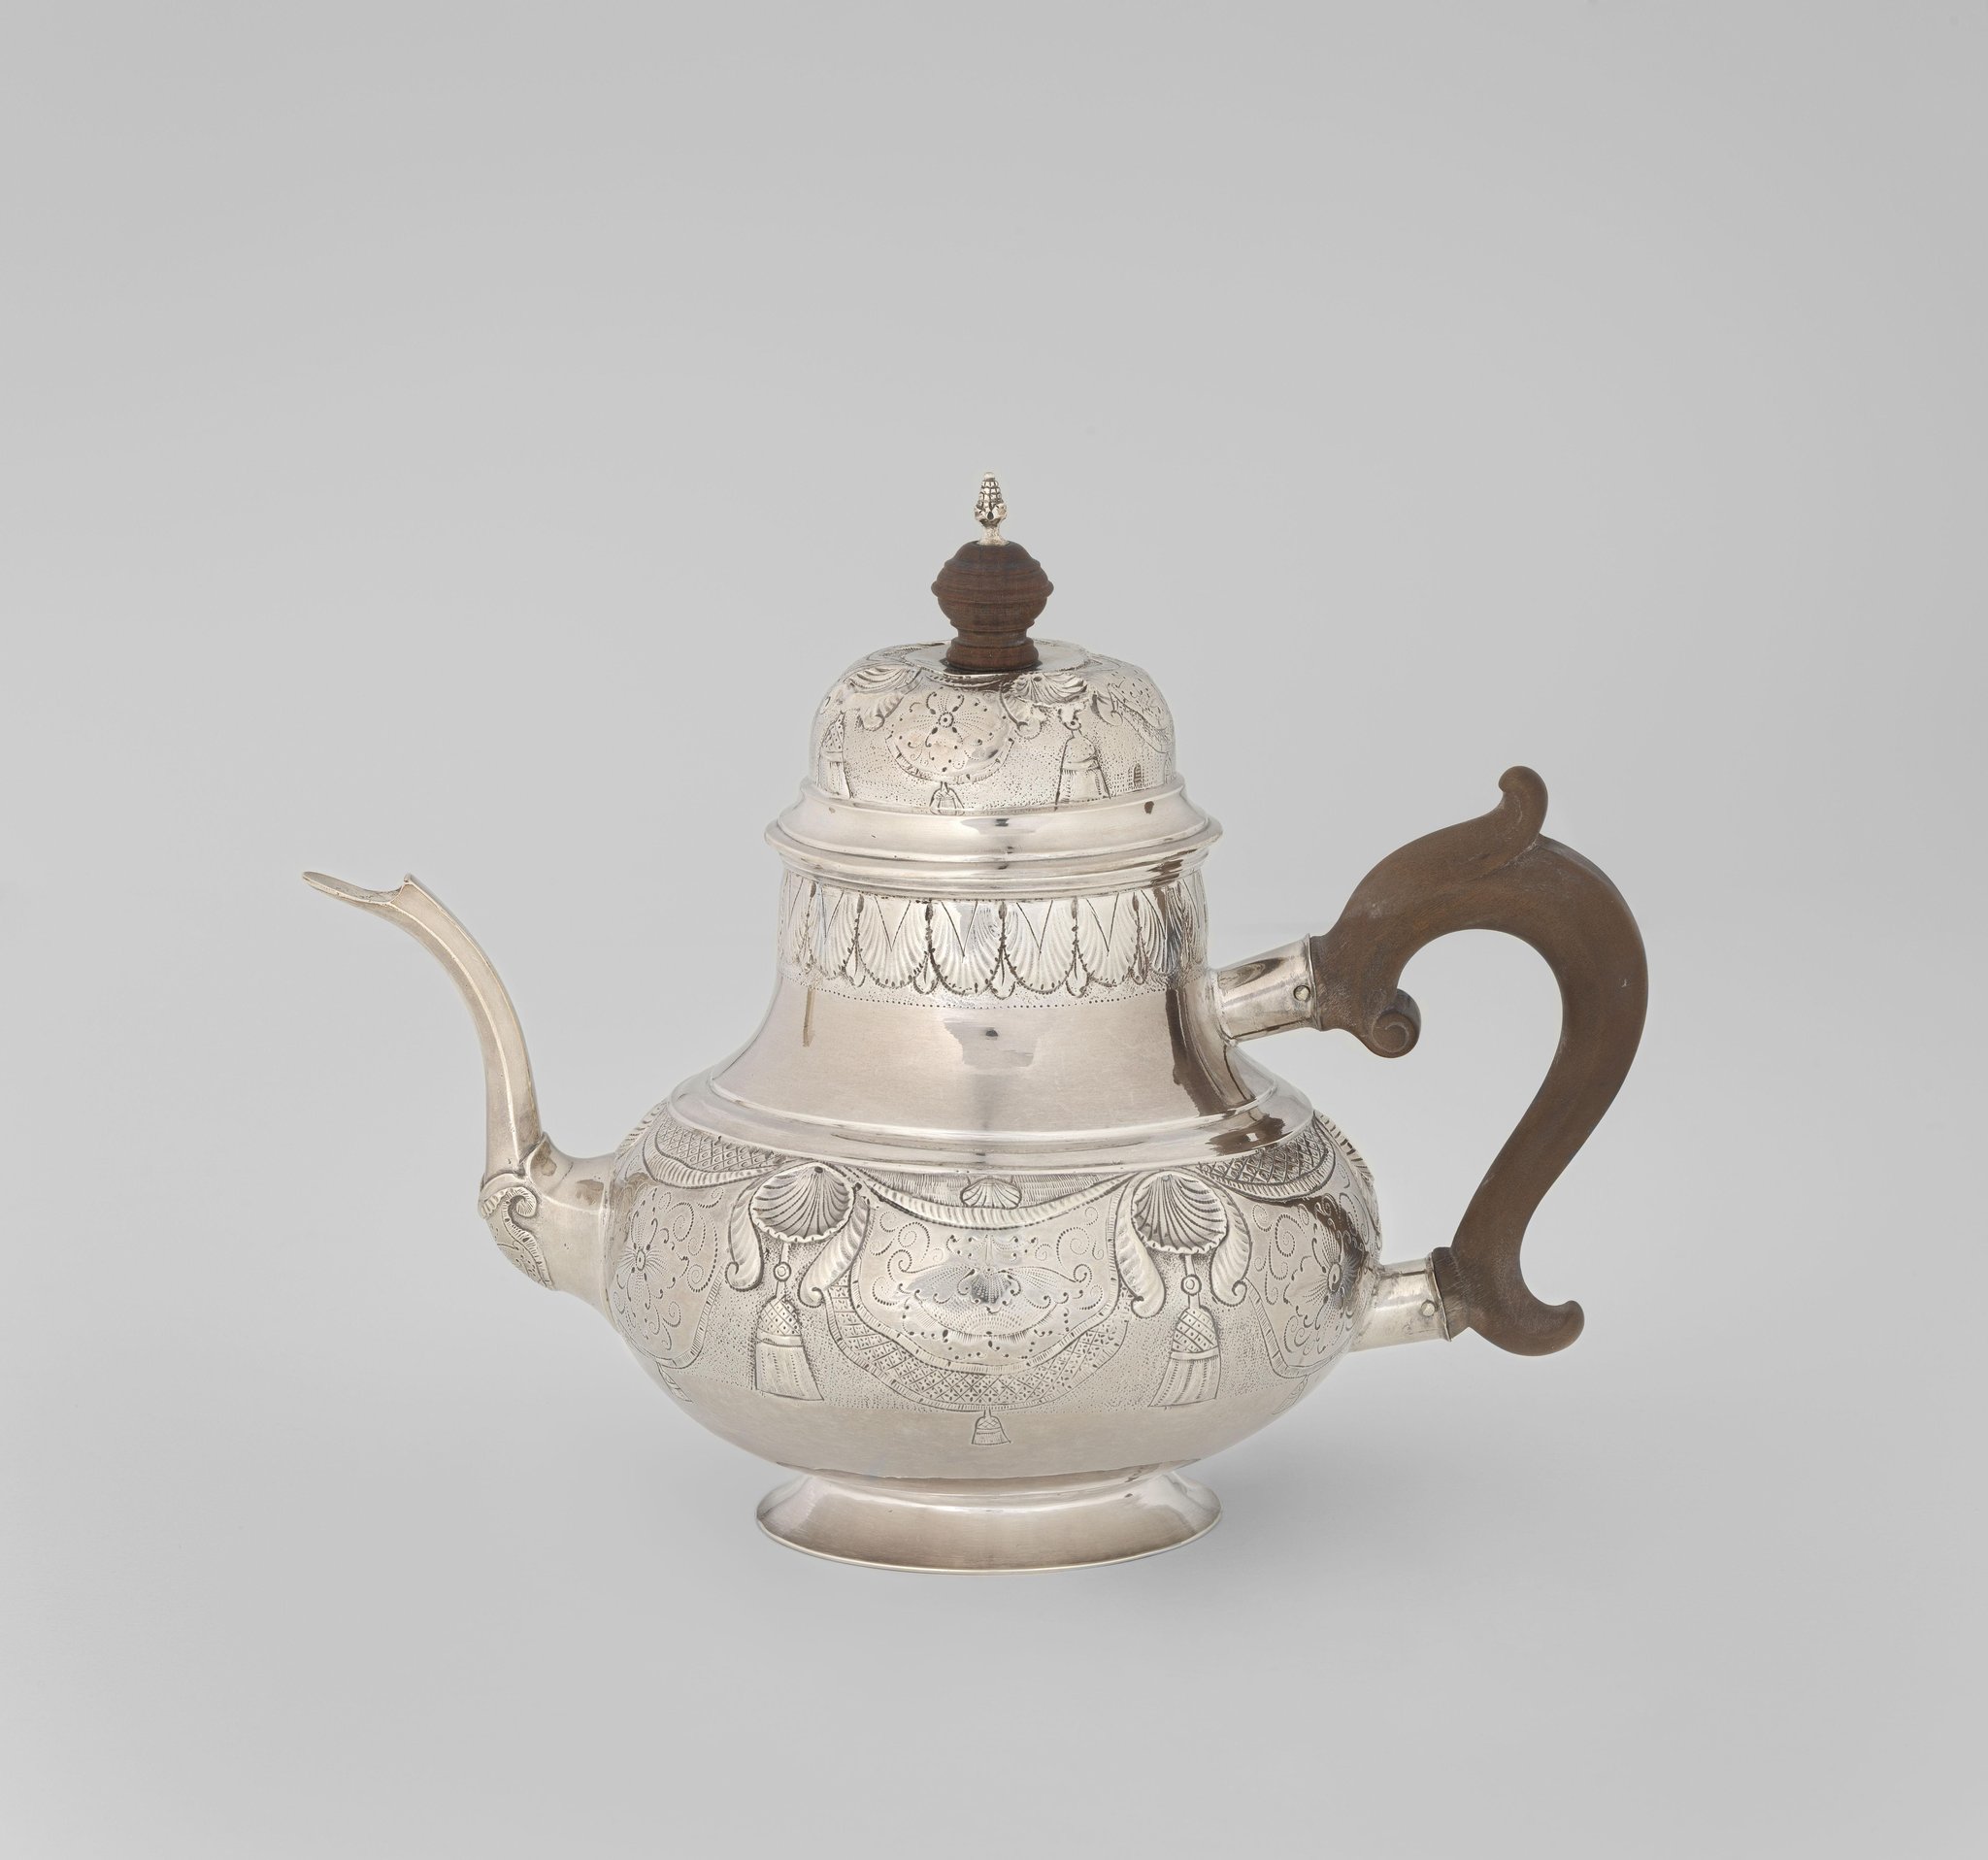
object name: teapot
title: Trekpot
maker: albert gaillard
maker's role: silversmith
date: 1746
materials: silver, wood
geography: haarlem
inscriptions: maker's mark: ‘AG, toegeschreven aan Albert Gaillard (Voet 117; Citroen 1988, nr. 162)’, : ‘schrijfletter L = Alkmaar 1795’, mark: ‘stadskeur Haarlem, jaarletter M = 1746’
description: De ronde pot rust op een holle standring, en heeft een lichaam dat bestaat uit een gedrukt bol en een gerekt hol gedeelte, gescheiden door bolle profielen, en aan de bovenzijde afgesloten door een dubbele bolle rand. Het bol gewelfde deksel heeft een dubbele profielrand en wordt bekroond door een vaasvormige knop, waarvan het lichaam in hout is uitgevoerd. Het onderste deel van het lichaam is versierd met dekkleden, kwasten en ingedreven schelpen, dat op het deksel wordt herhaald ; het gerekt holle deel aan de bovenzijde met een bladrand. Het recht uitstaande S-vormige houten oor is gevat in rechte zilveren manchetten. Het onderste gedeelte van de ingesnoerde, S-vormige tuit heeft de vorm van een bloemkelk met facetten.